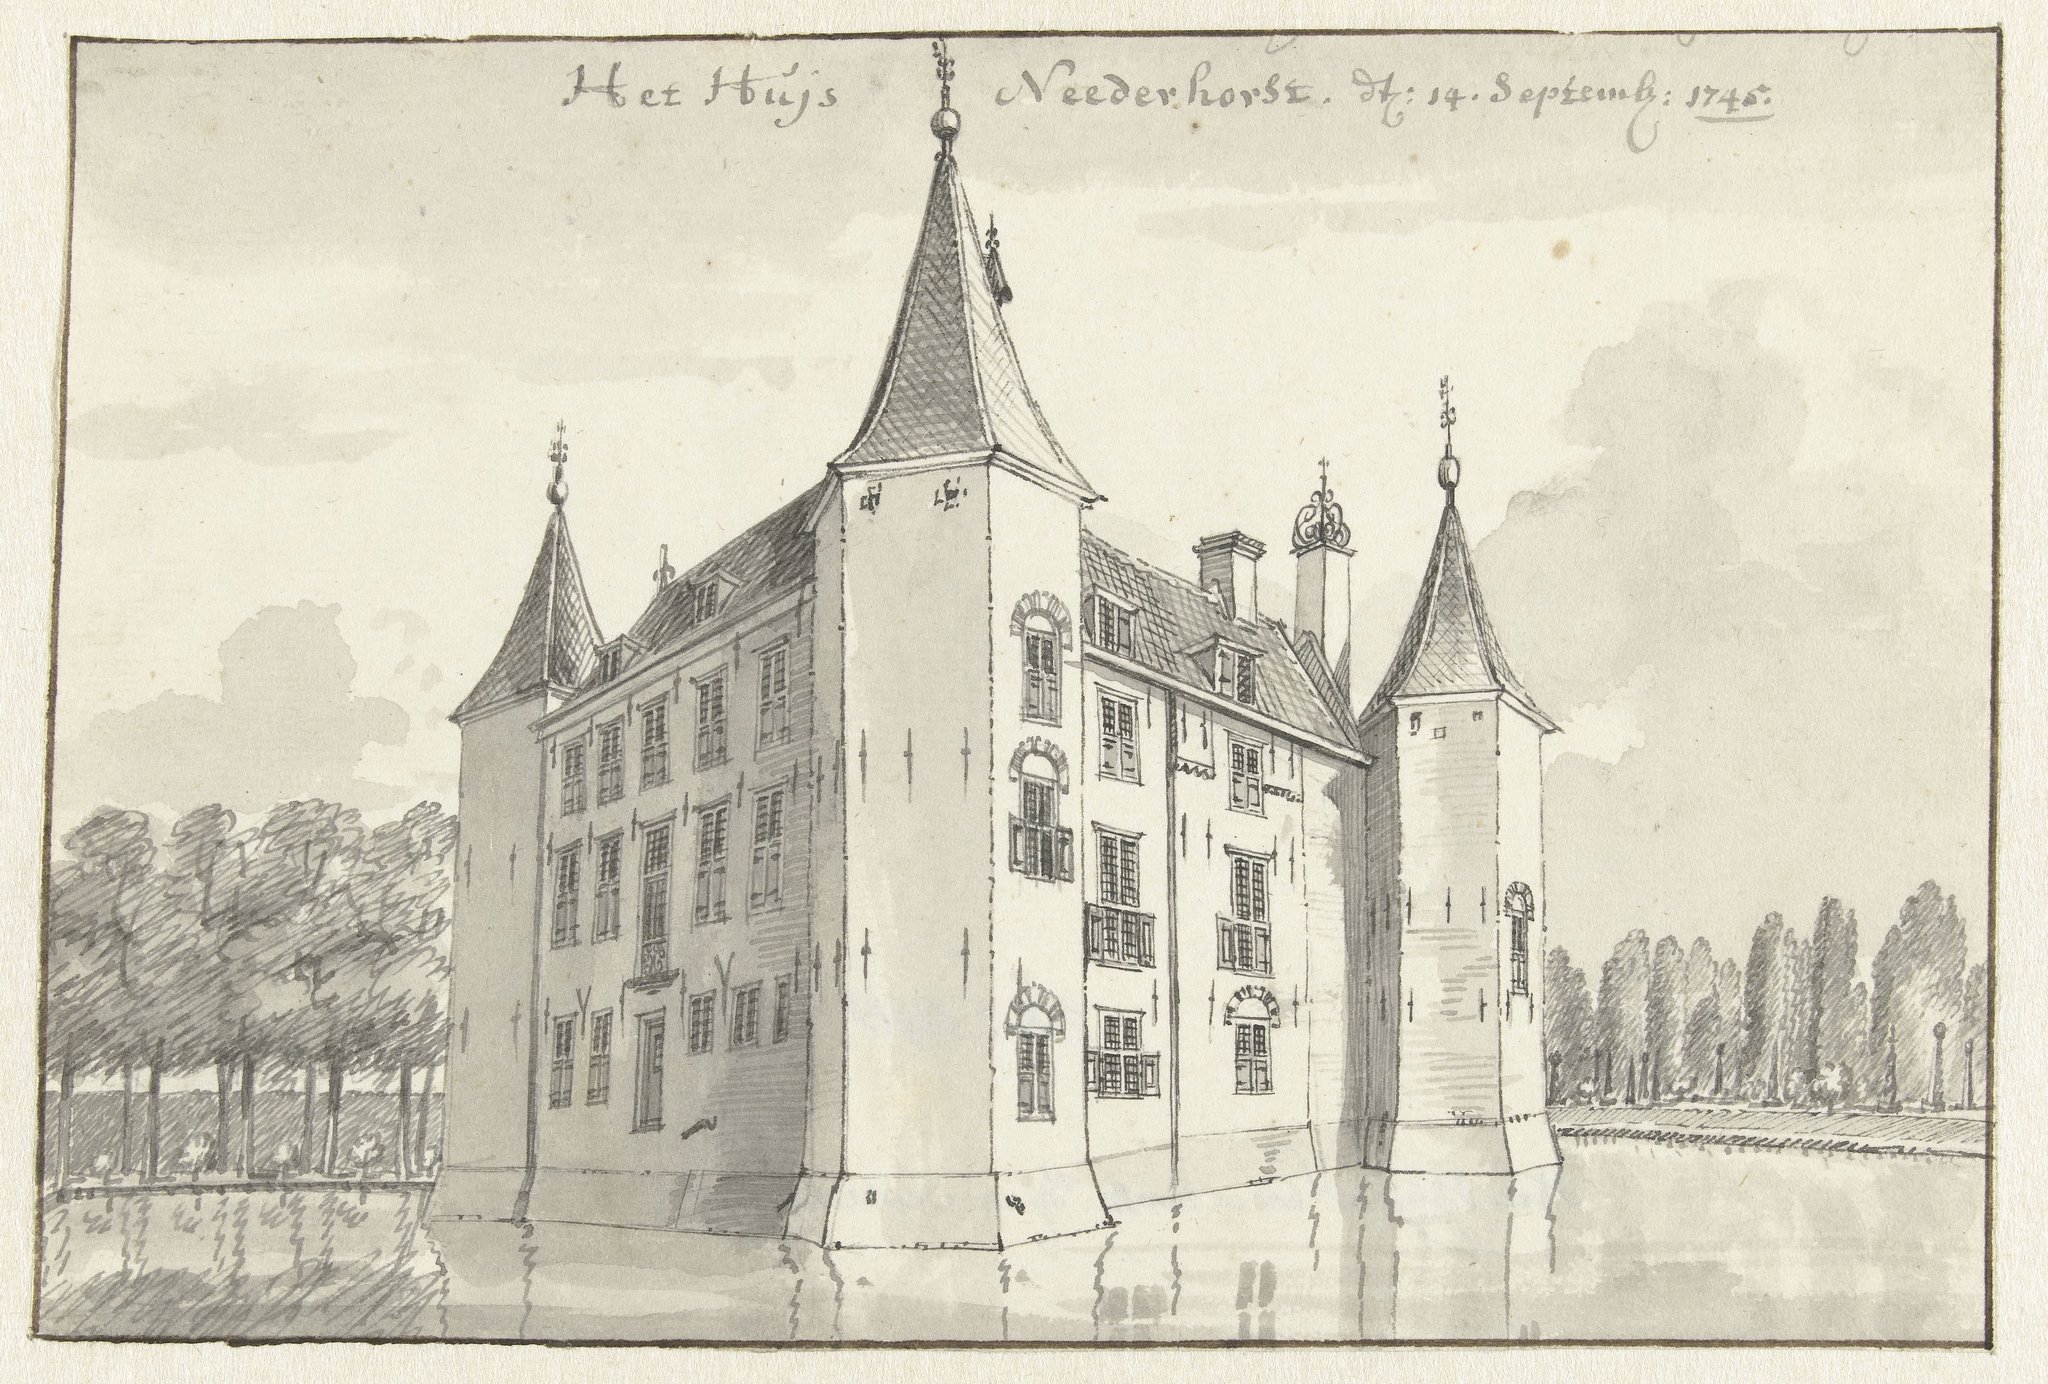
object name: drawing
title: Nederhorst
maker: jan de beijer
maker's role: draughtsman, print maker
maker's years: 1703-1780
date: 1745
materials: ink, paper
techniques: brush, pen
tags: castle, nederhorst den berg